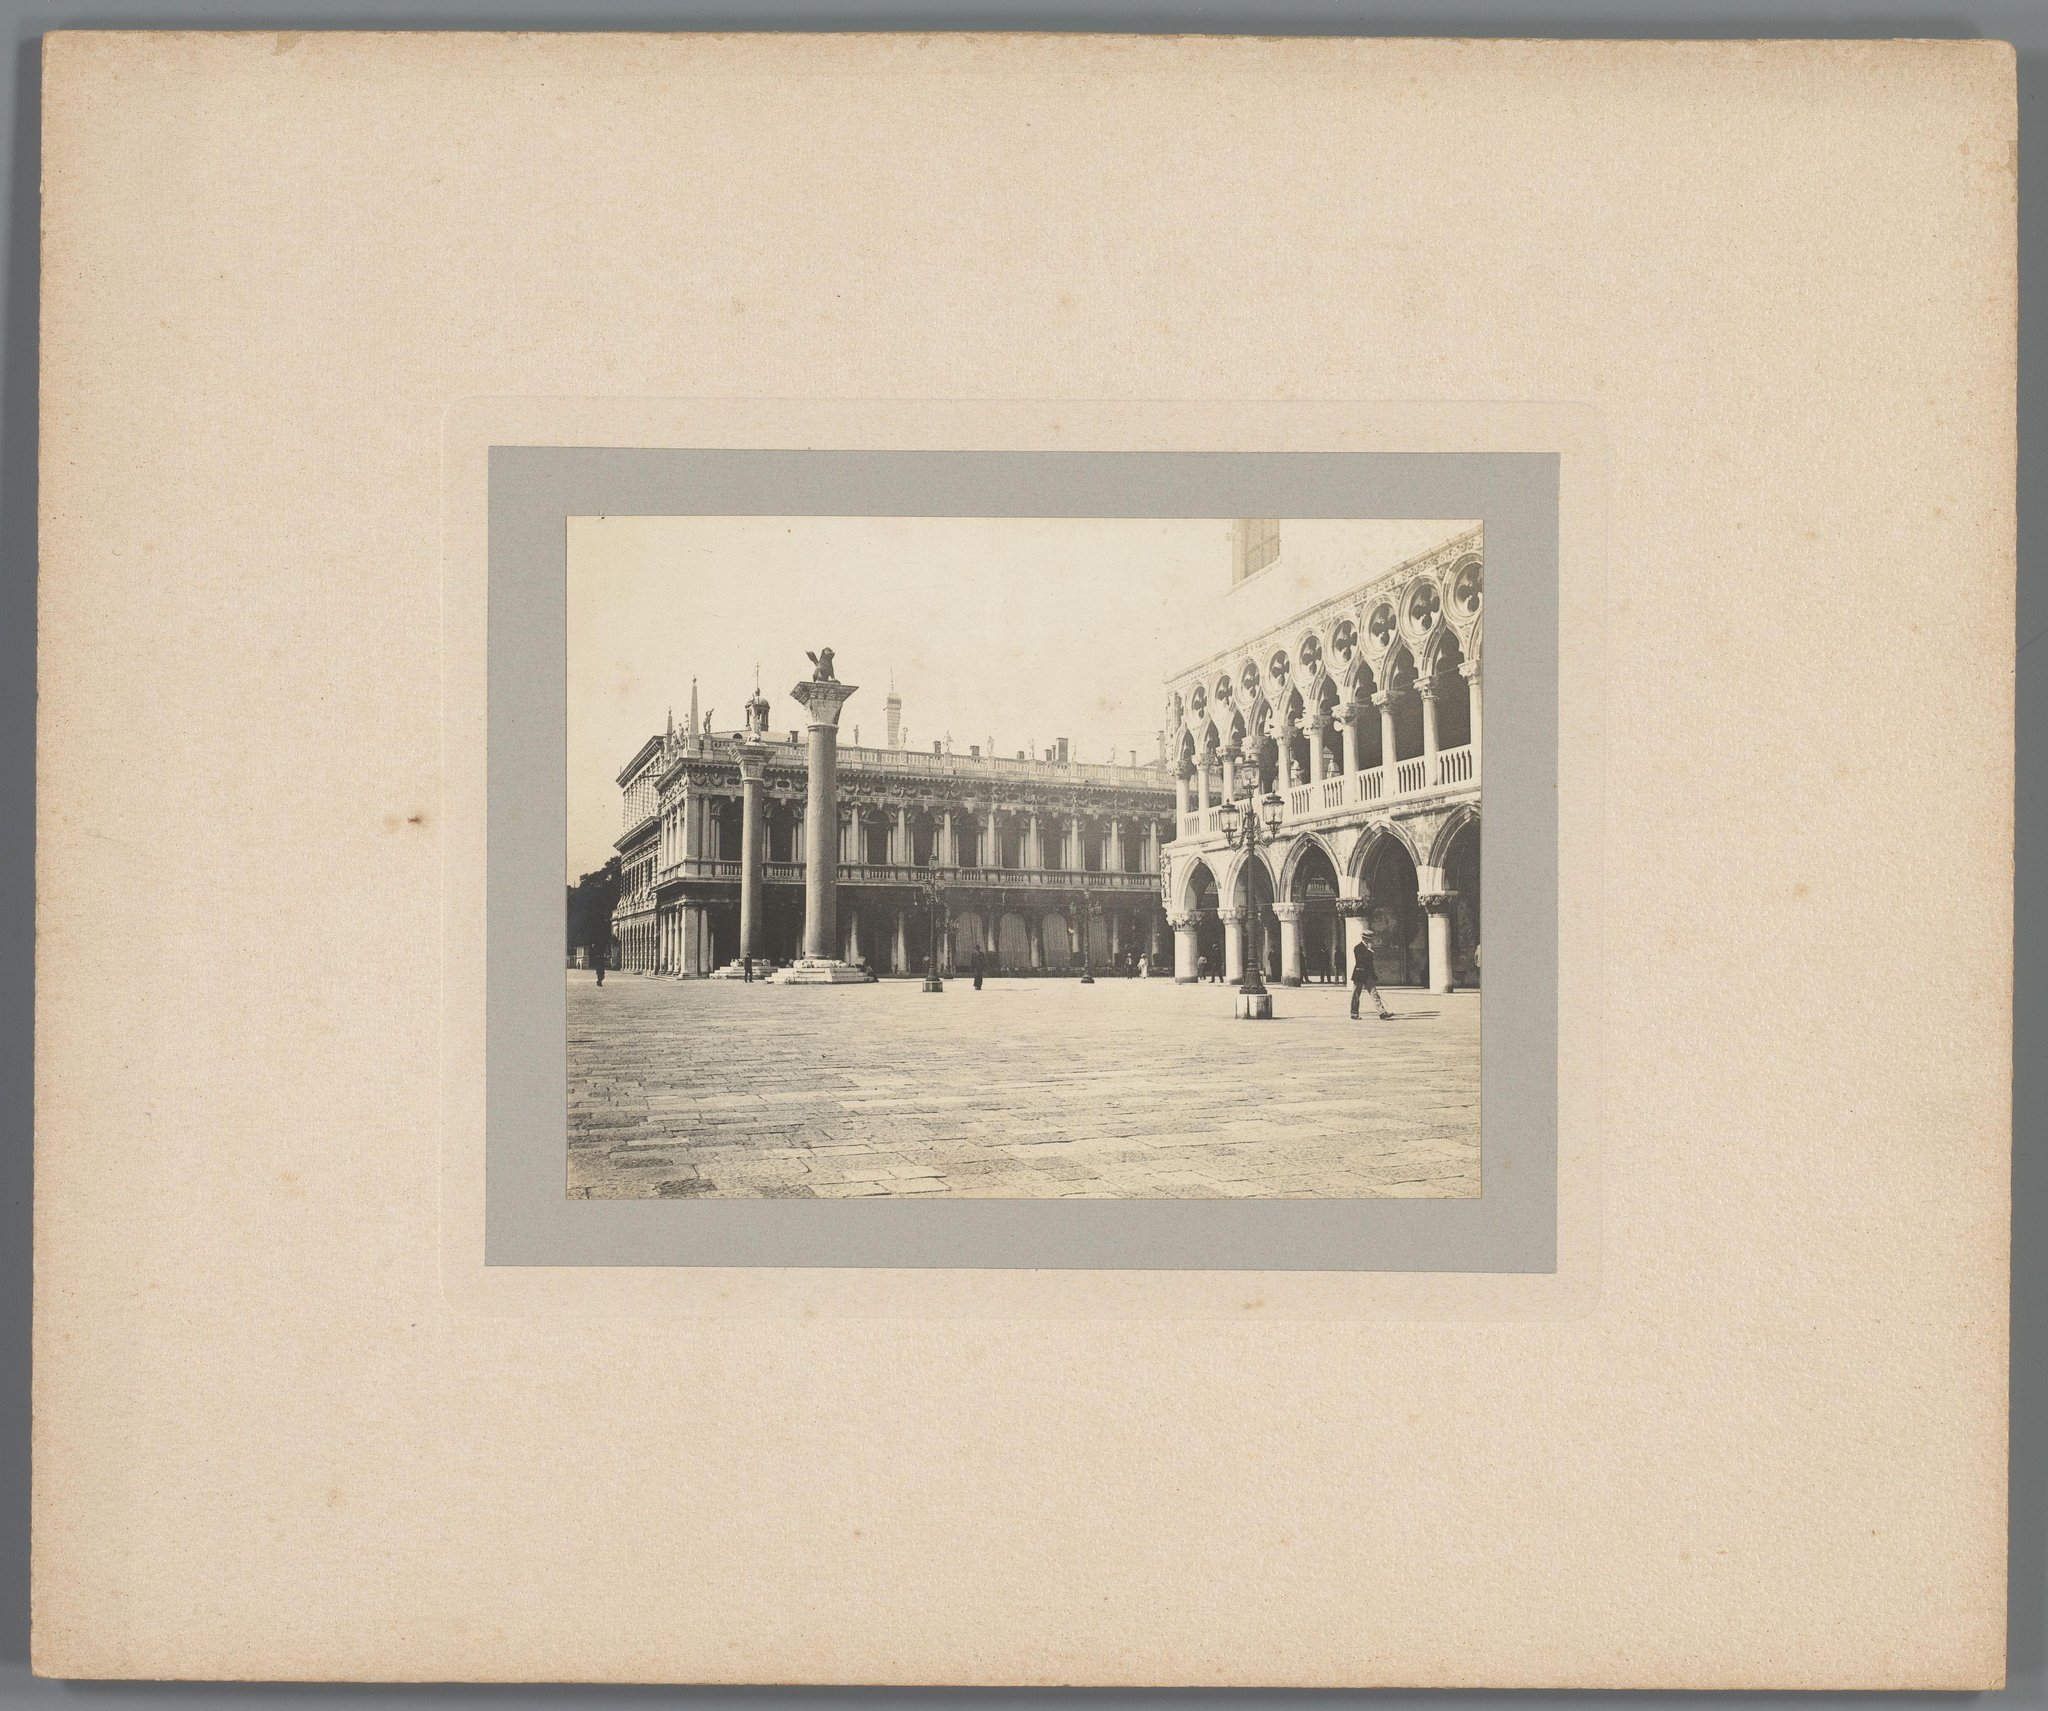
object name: photograph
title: Dogepaleis en de Riva degli Schiavoni, Venetië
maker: françois buys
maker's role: advocaat, amateurfotograaf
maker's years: 1871-1934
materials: paper, cardboard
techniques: gelatin silver print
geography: venice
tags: palace, avenue, boulevard, promenade, esplanade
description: Deze foto maakt deel uit van een groep van 38 foto's.